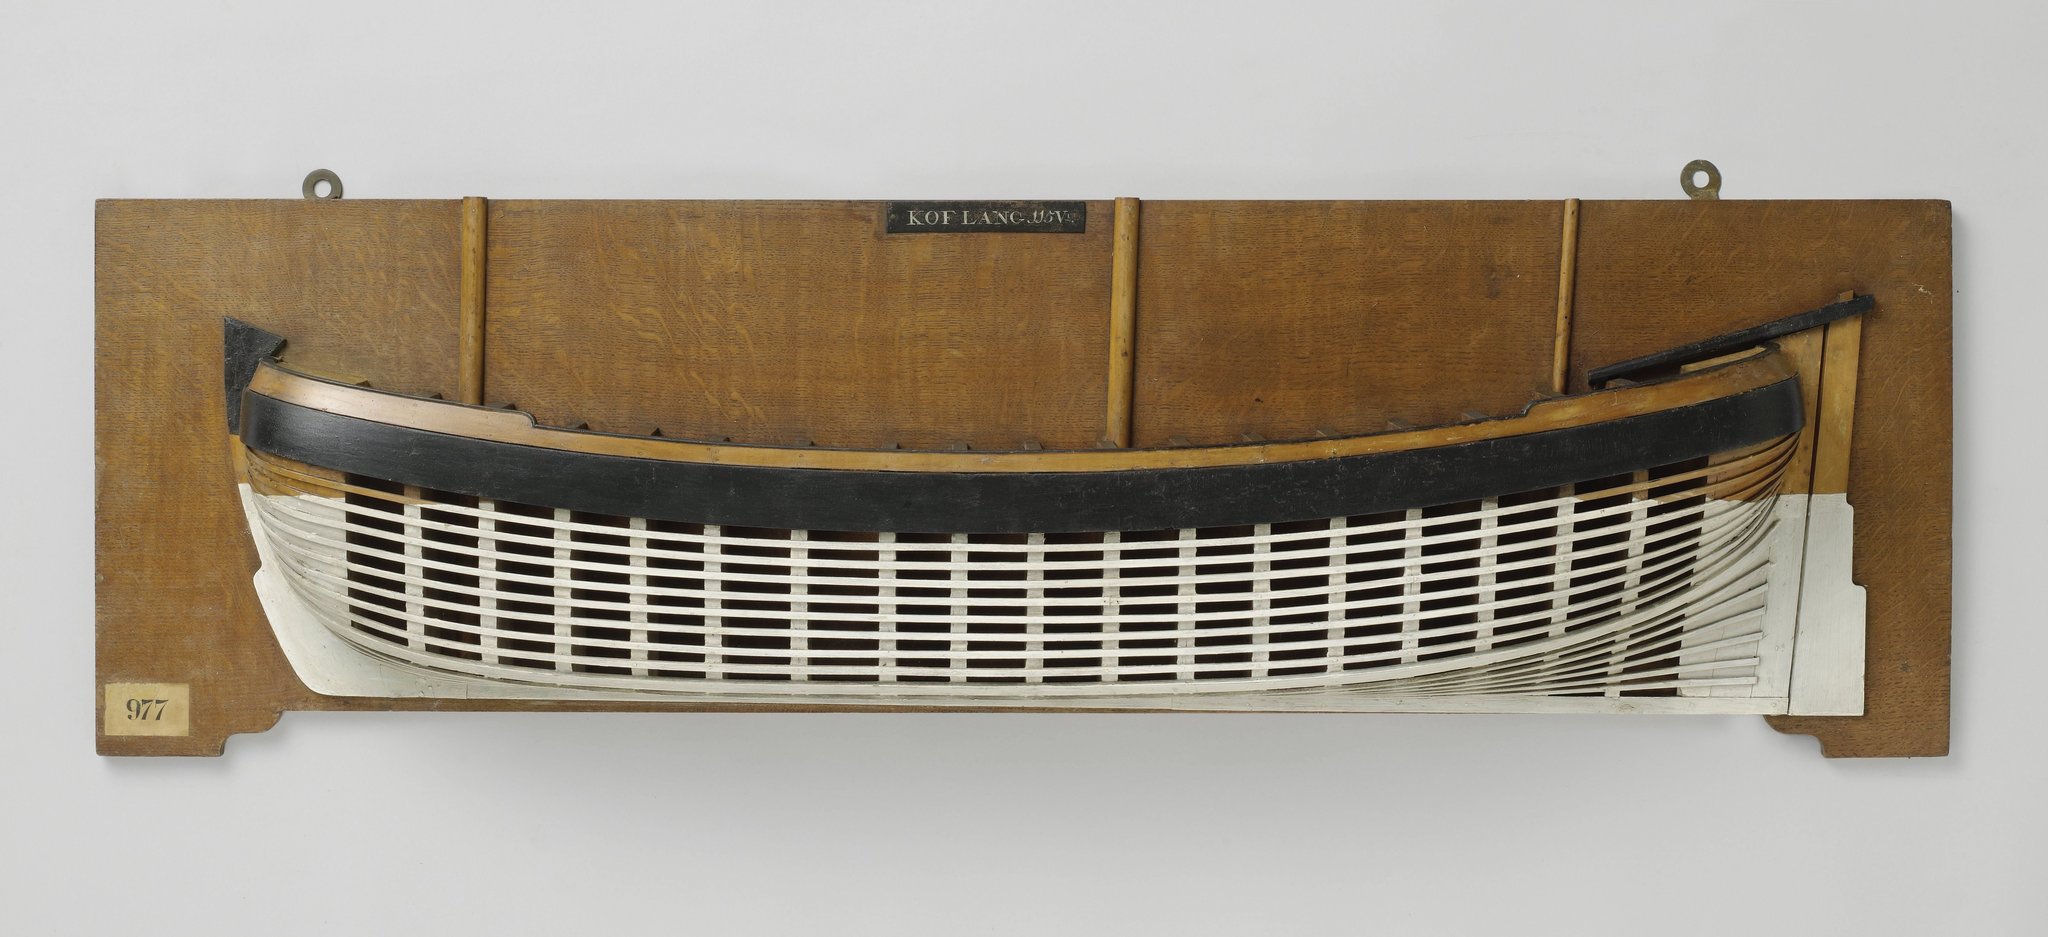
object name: ship model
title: Half model of a Dutch kof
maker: Anonymous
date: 1780-1820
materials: wood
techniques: polychromy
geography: netherlands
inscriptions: inscription, top centre, on a rectangular black label: ‘KOF LANG 115 Vt.’, label, bottom left: ‘977’ former inventory label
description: Gepolychromeerd mallenmodel (bakboord) van een driemaster. Opvallend is het grote aantal spantmallen. De huid boven het barkhout is gesloten. Rond achterschip; recht roer met helmstok over het dek. De zeeg loopt op naar beide uiteinden, één barkhout. Rondspant met platte bodem. Schaal ca. 1:36 (afgeleid).